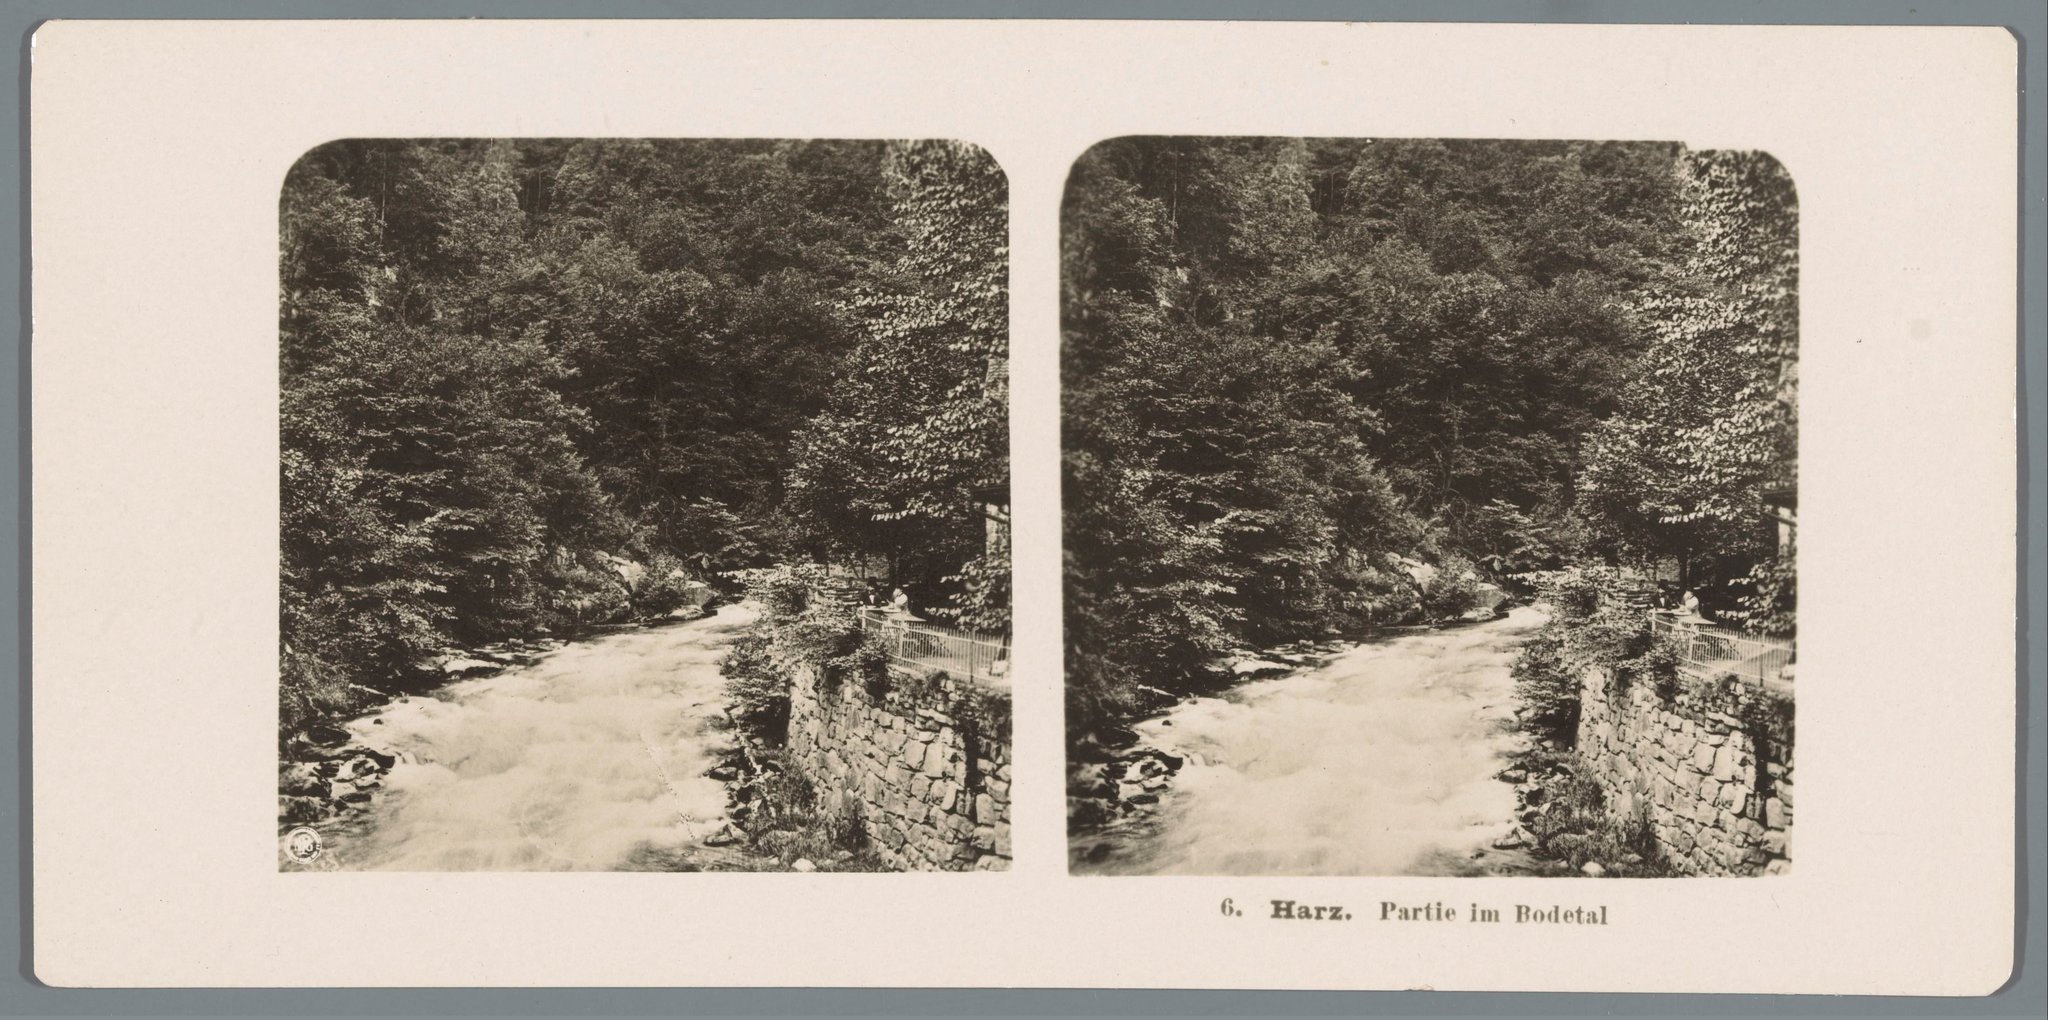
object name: stereograph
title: Stroomversnelling in het Bodetal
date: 1900-1910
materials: cardboard, photographic support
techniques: gelatin silver print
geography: bodetal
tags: dale, valley, rapids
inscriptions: number: ‘6.’, inscription: ‘NPG’